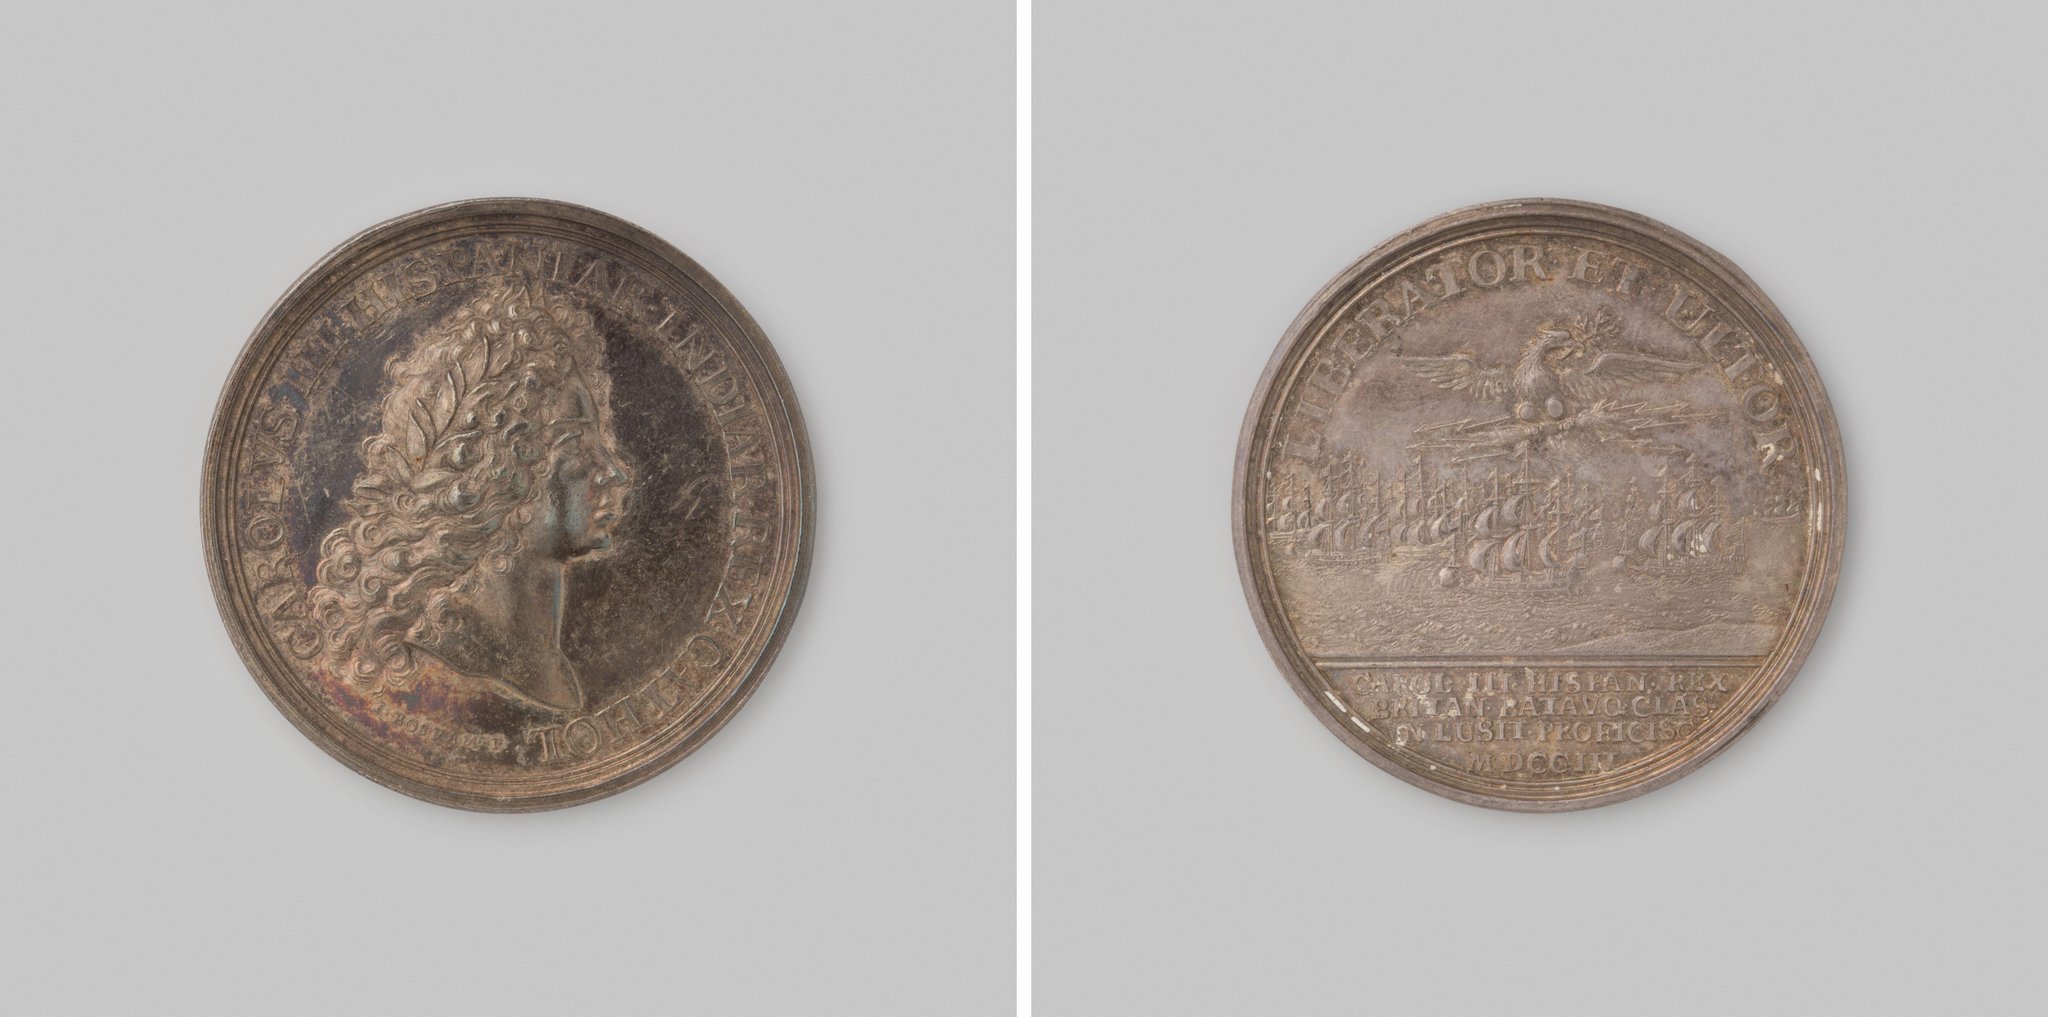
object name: history medal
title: Vertrek van Koning Karel III van Spanje naar de Engels /Nederlandse vloot in Portugal 1703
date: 1703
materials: silver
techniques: striking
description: Zilveren penning, op de voorzijde het portret van Karel naar rechts met omschrift, op de keerzijde een adelaar met bliksem én vredestak boven de vloot op volle zee, met omschrift en afsnedetekst.